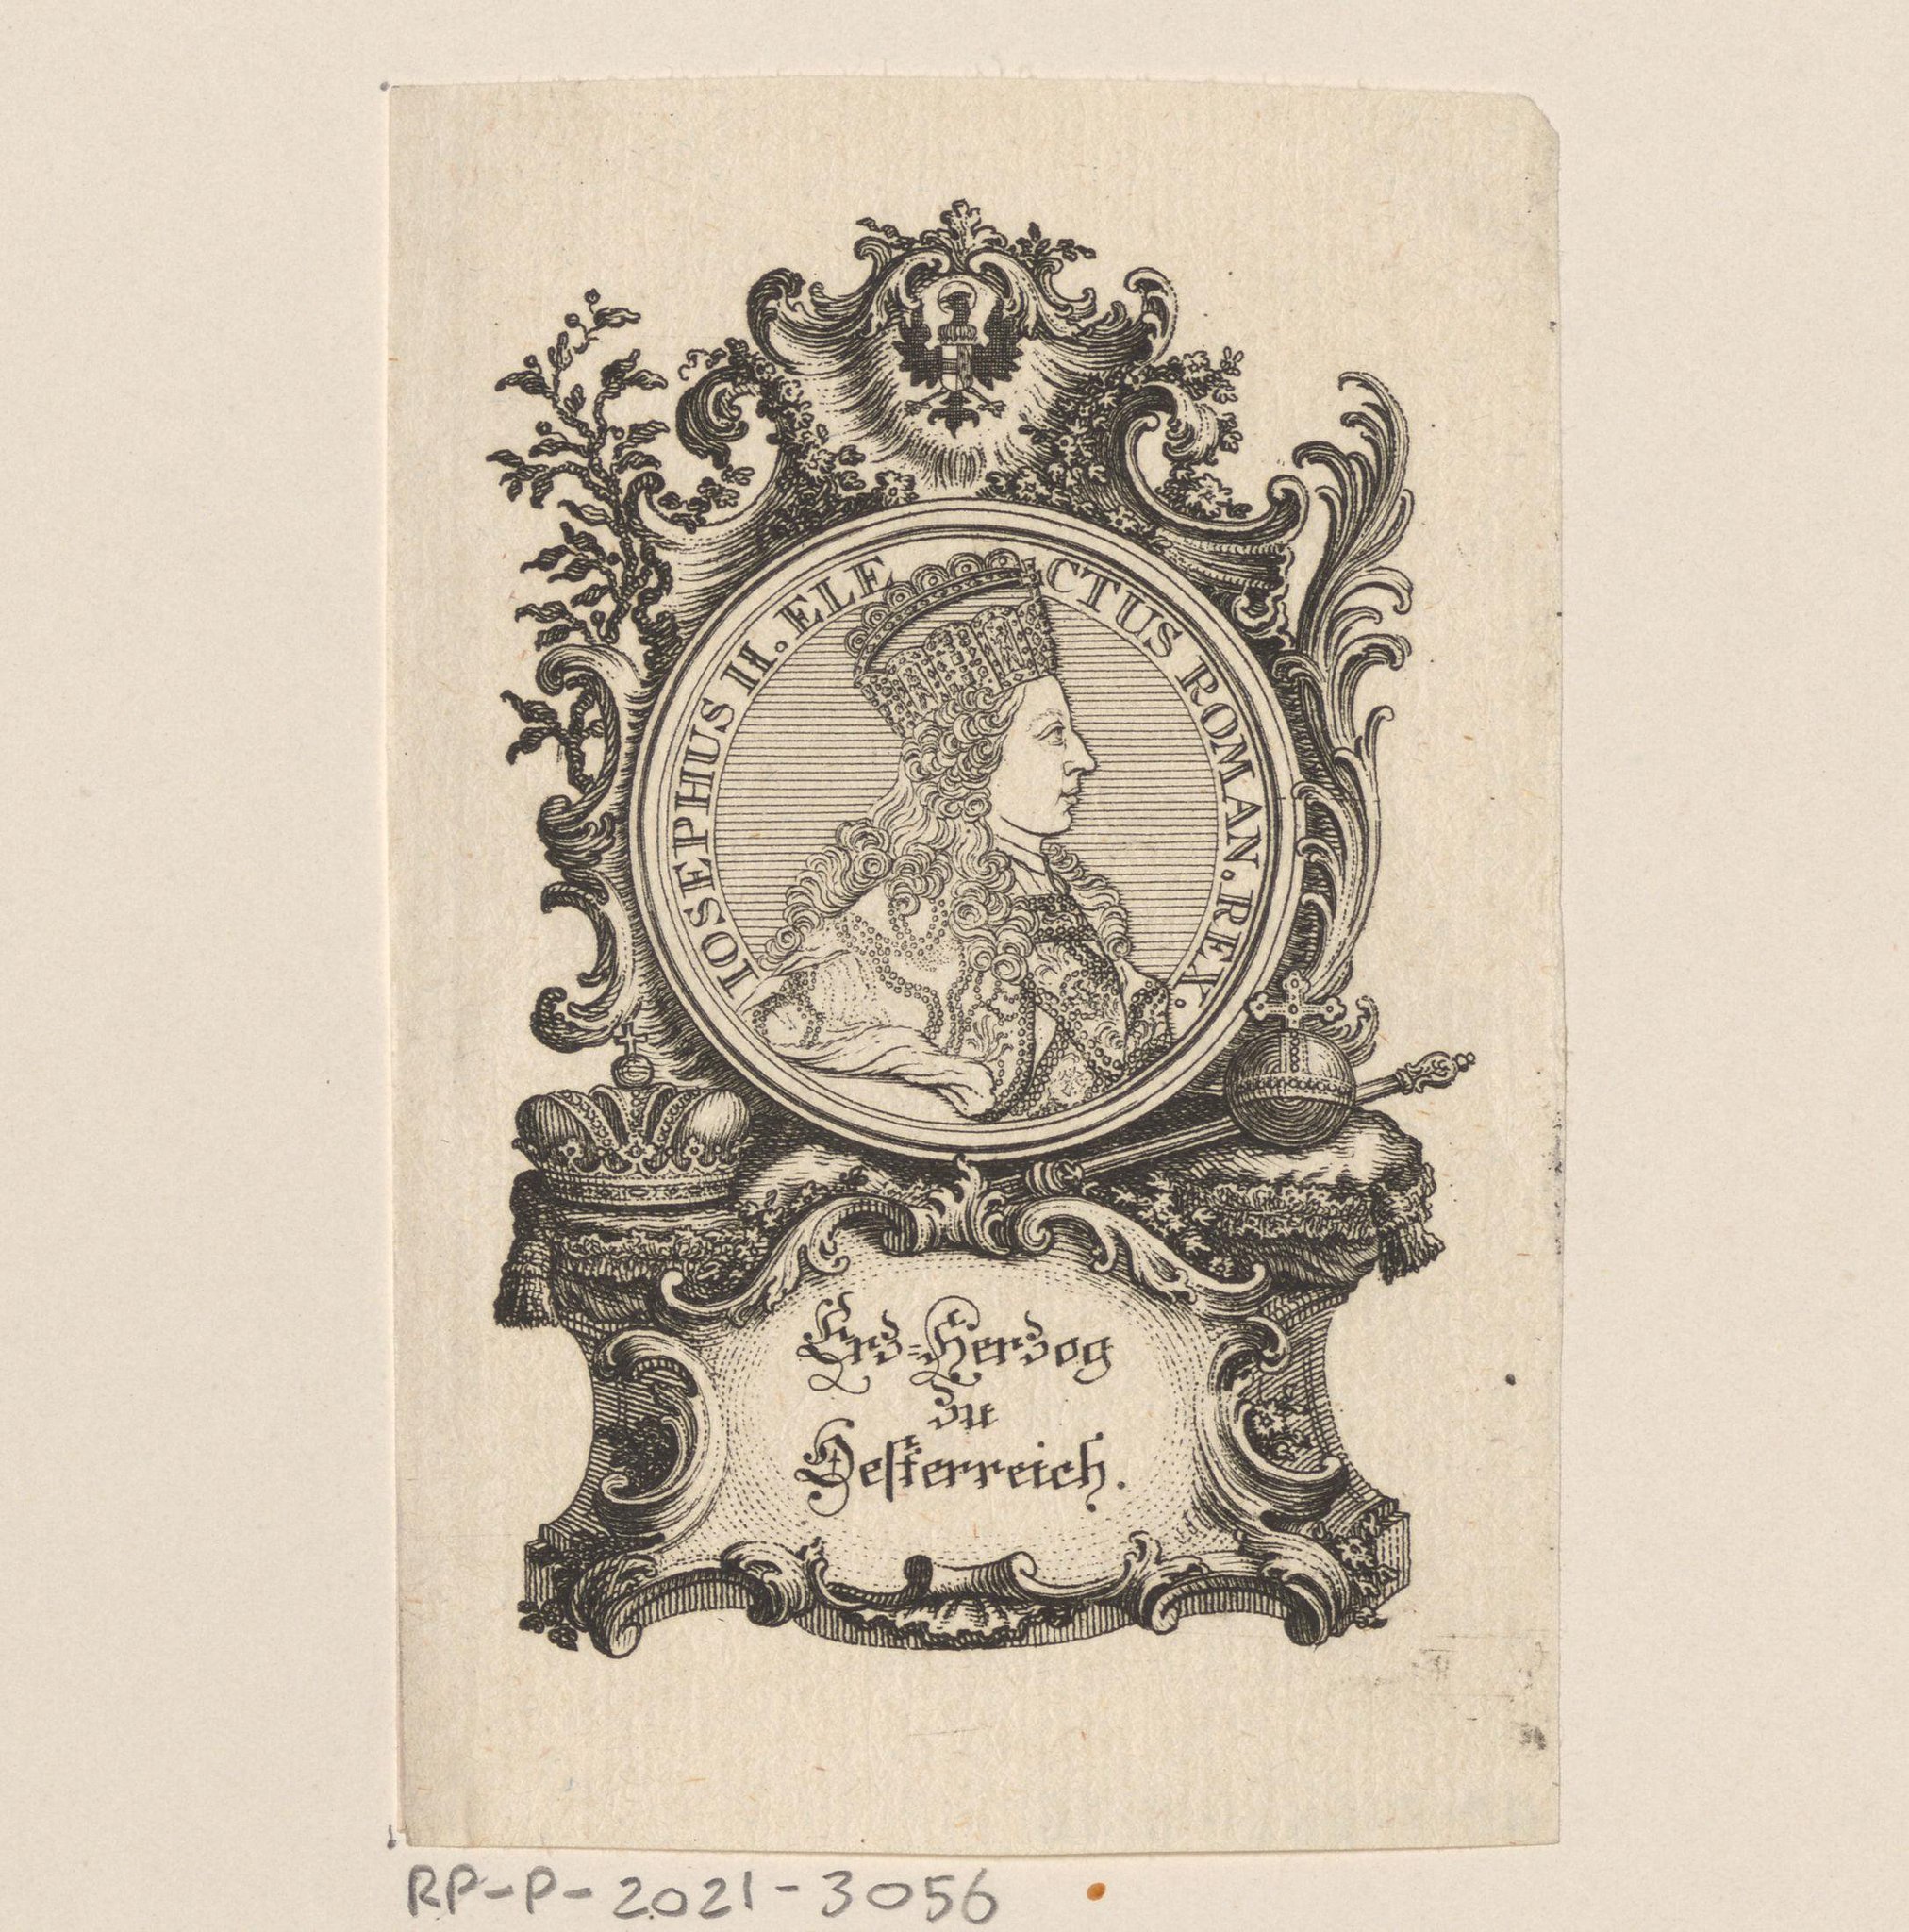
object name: print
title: Portret van Jozef II, Duits keizer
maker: Anonymous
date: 1780-1790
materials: paper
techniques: engraving, etching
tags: vienna, jozef ii (duits keizer), crown (symbol of sovereignty), historical persons, emperor